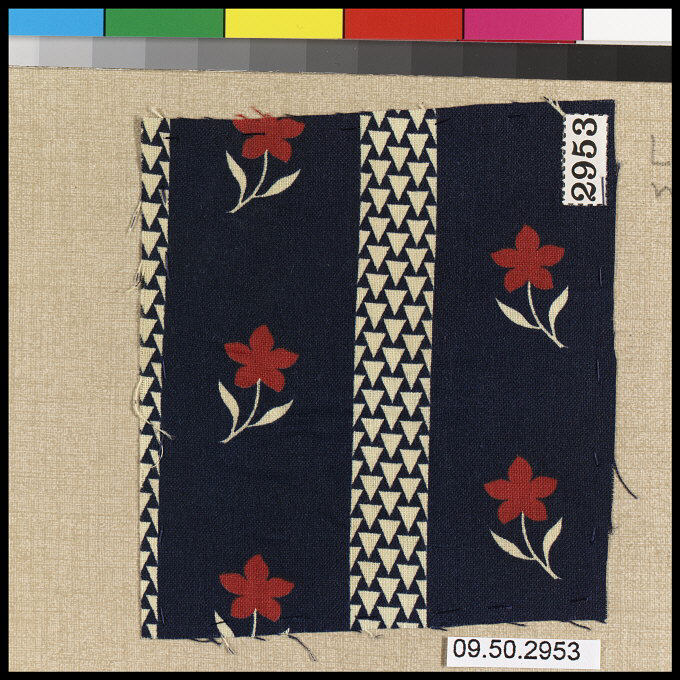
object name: piece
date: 1801-1900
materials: cotton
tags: flowers,leaves